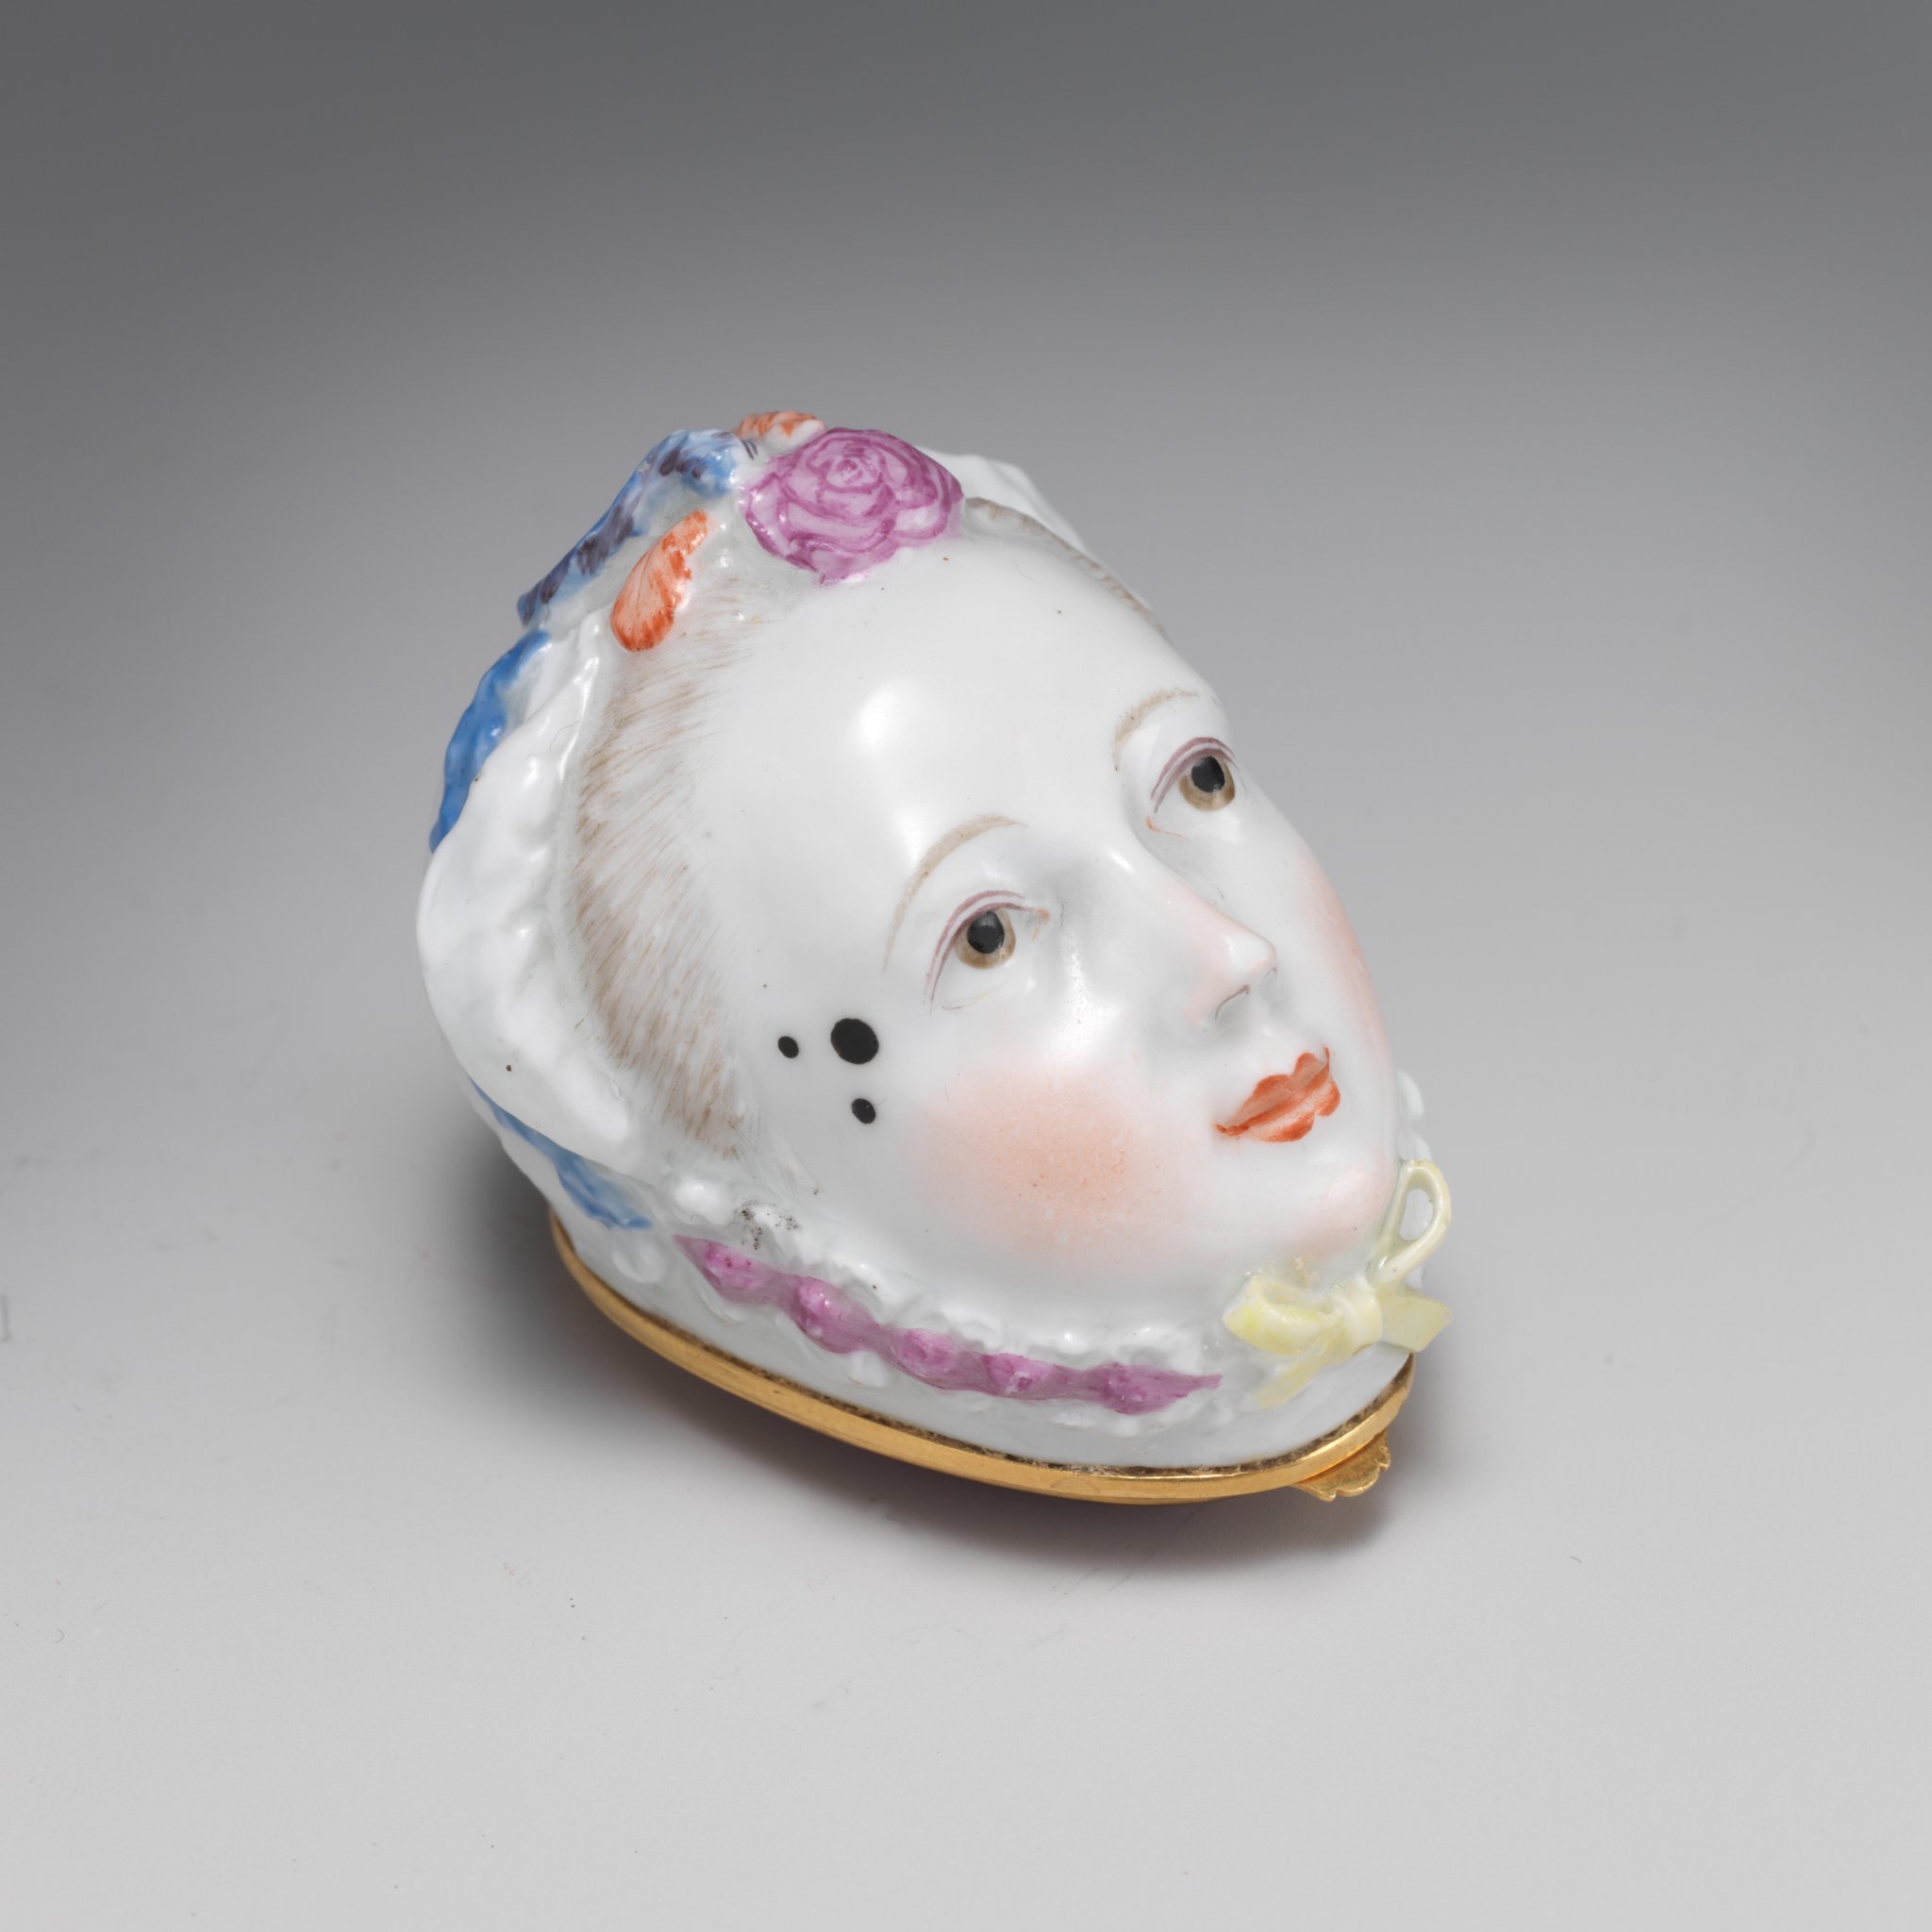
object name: toy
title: Lady's head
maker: chelsea porcelain manufactory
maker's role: factory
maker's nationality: british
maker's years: 1744-1784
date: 1760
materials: soft paste porcelain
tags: heads,women